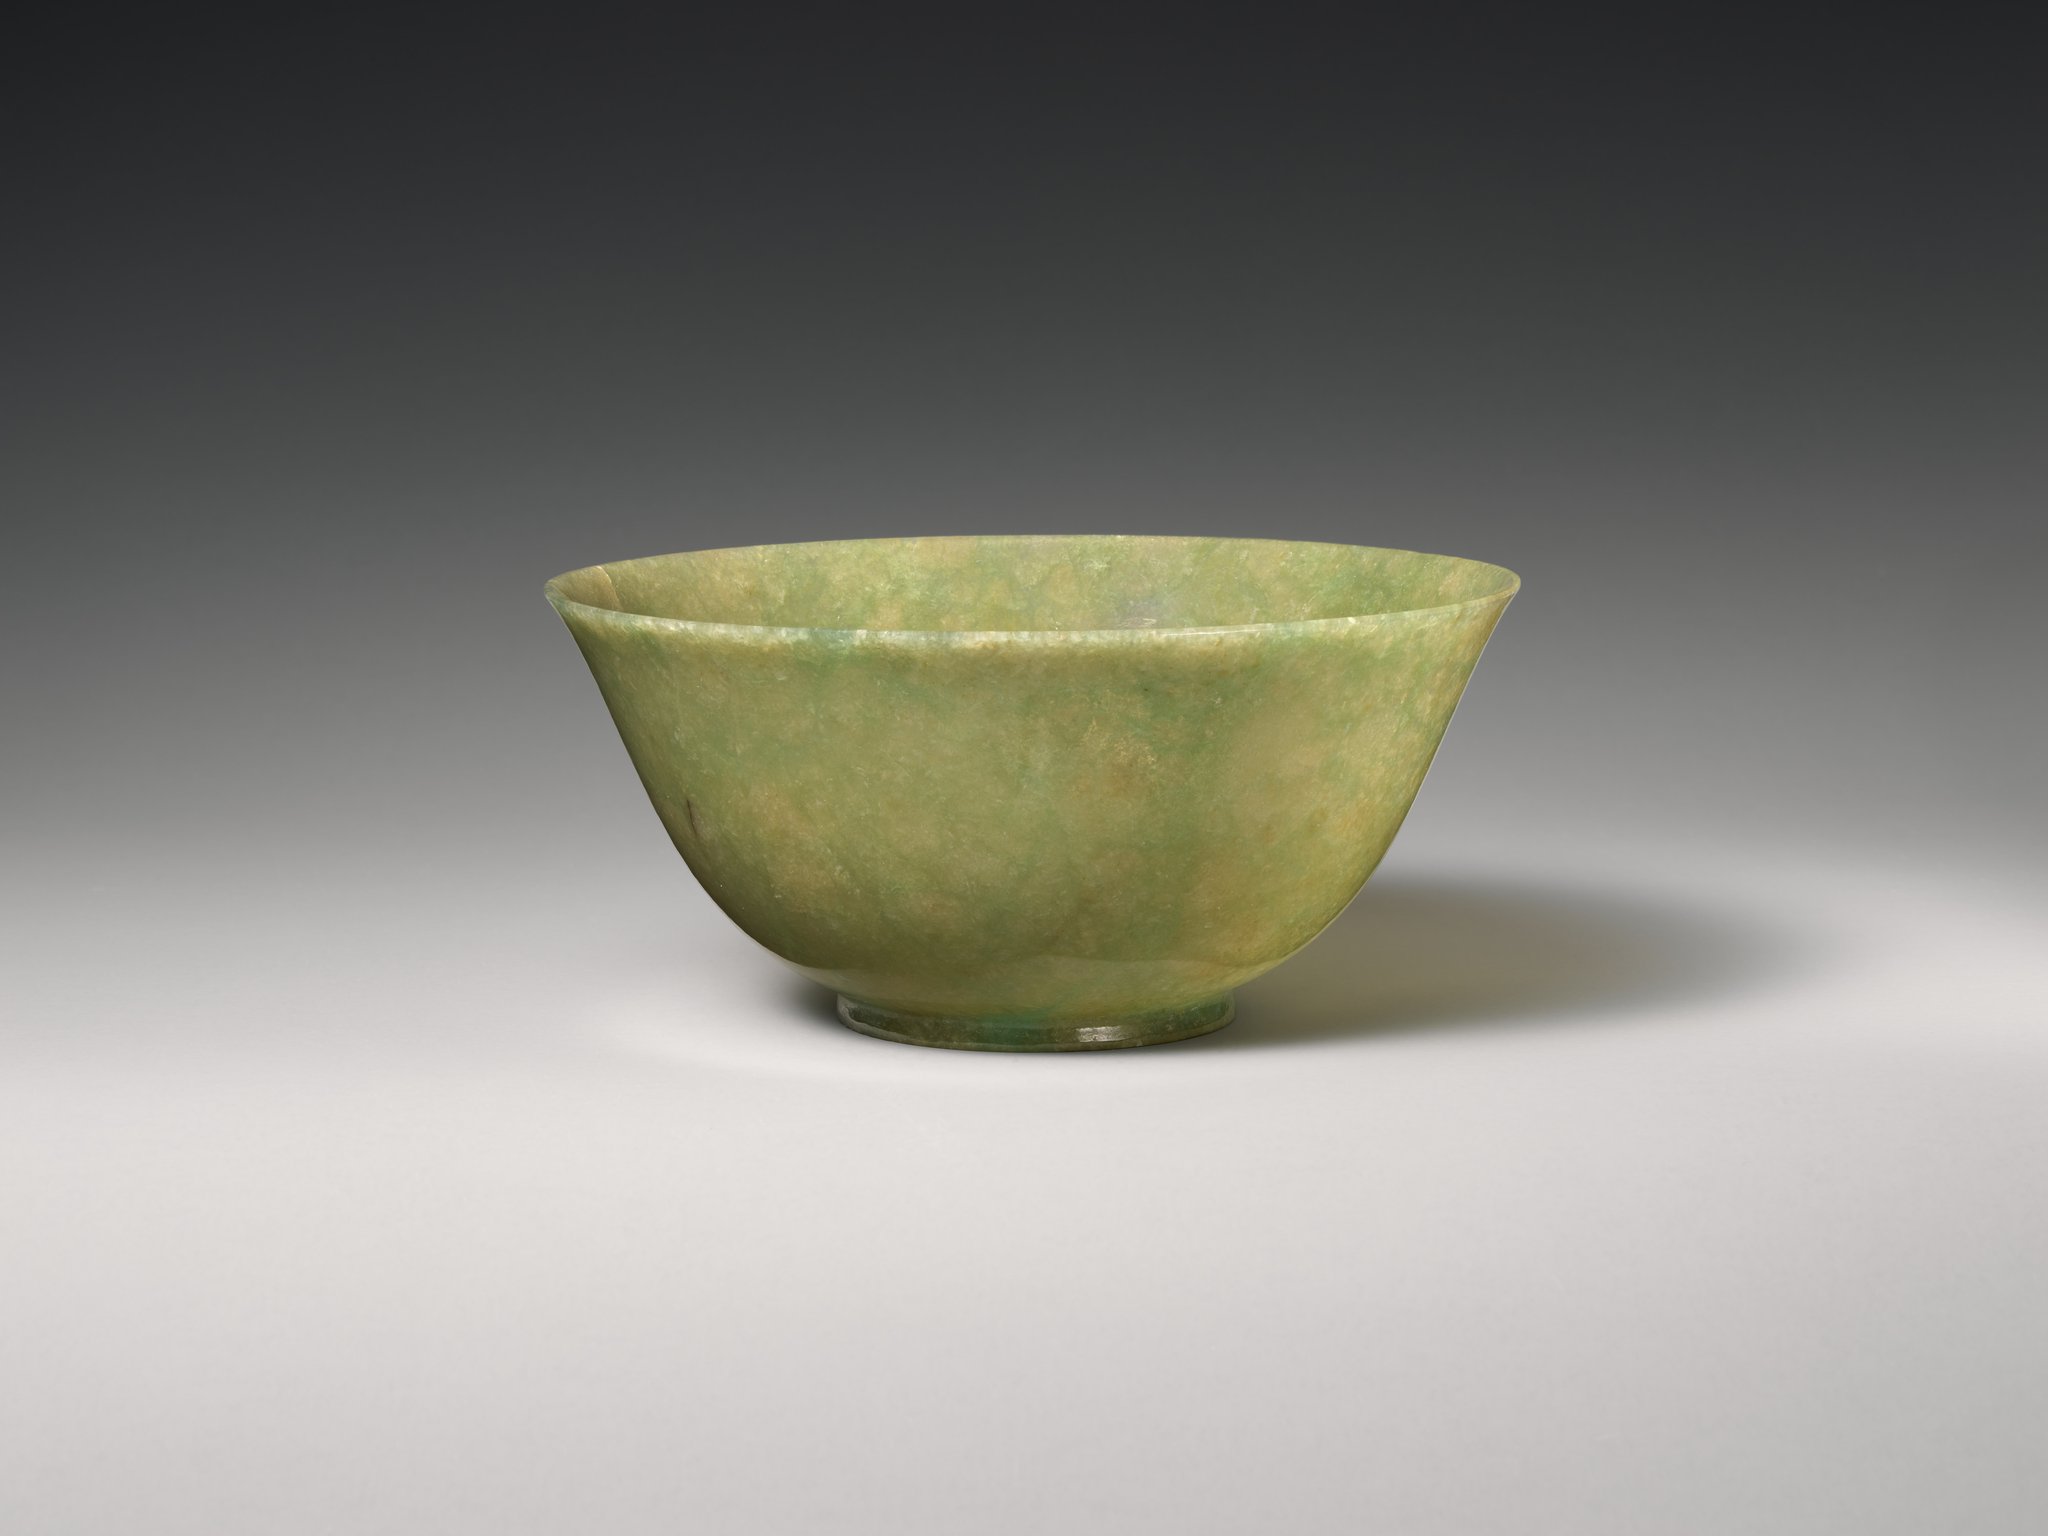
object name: bowl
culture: chinese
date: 1662-1722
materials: jade